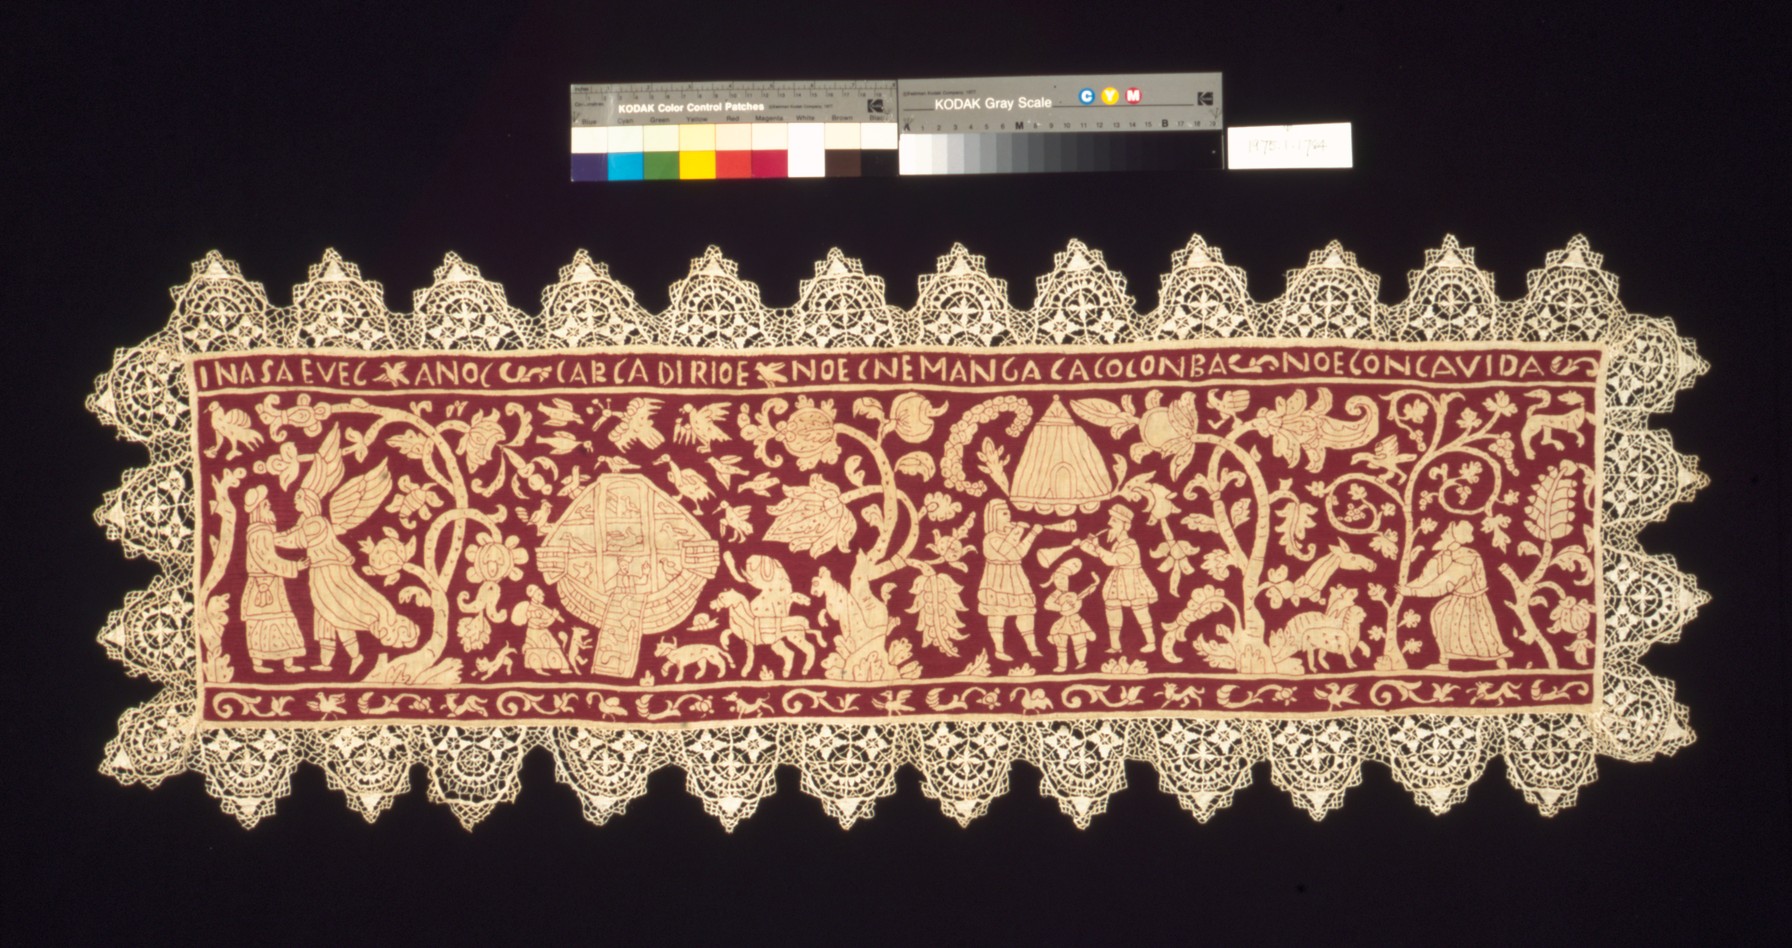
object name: textile panel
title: Panel with Noah's Ark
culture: italian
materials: linen, silk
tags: animals,men,noah